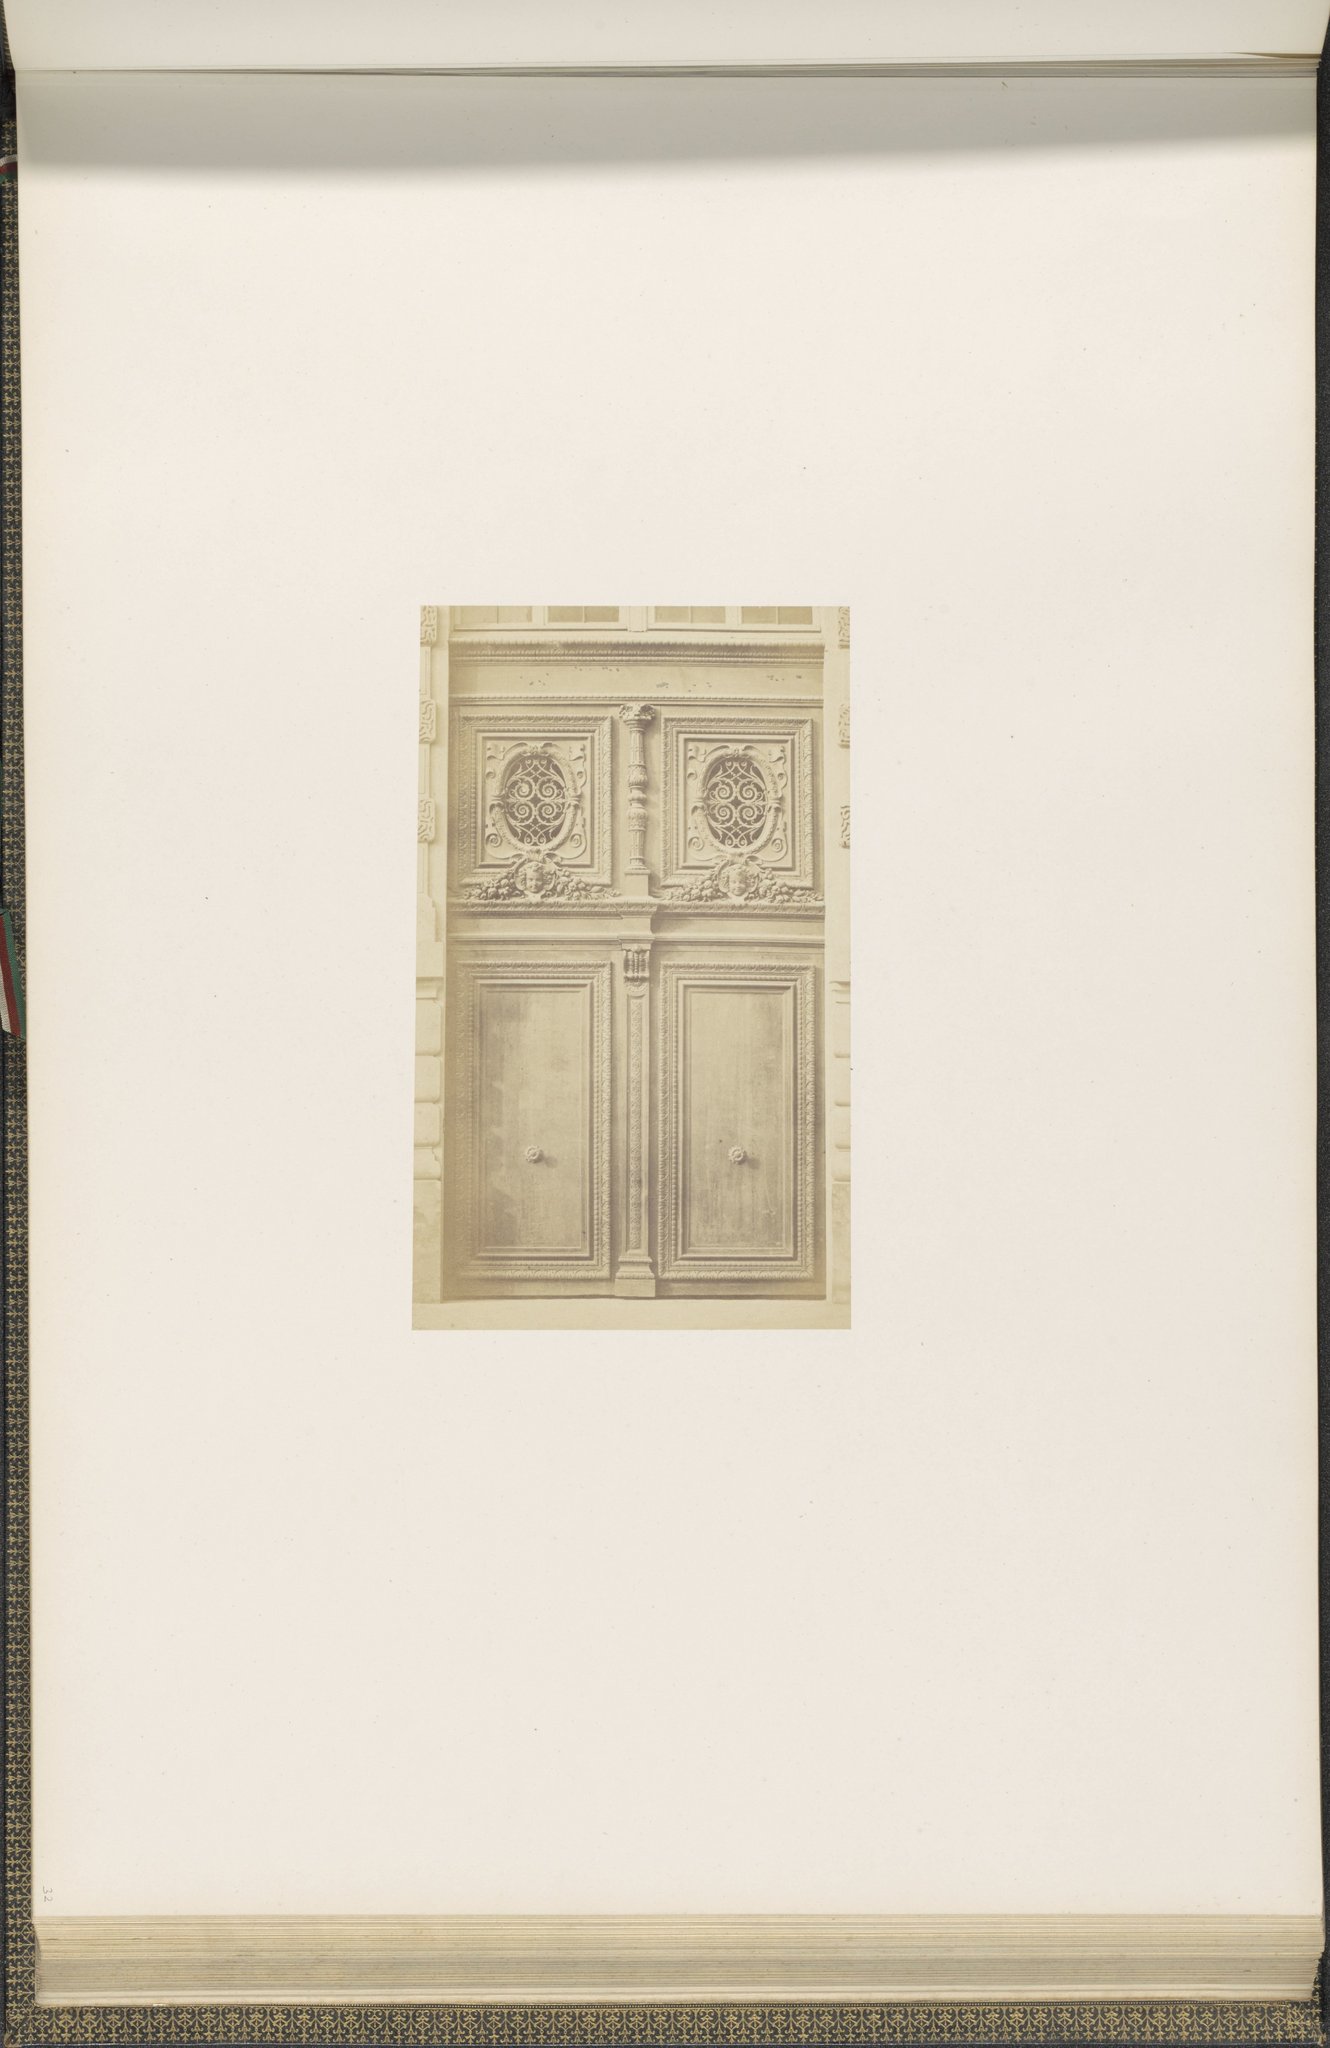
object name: photograph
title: Deur van de Bibliothèque Impériale van het Palais du Louvre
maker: édouard denis baldus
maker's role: fotograaf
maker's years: 1813-1889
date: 1855-1857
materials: paper, photographic support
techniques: salted paper print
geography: paris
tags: door, permanent exhibition, museum, ornamenting, decorating ~ applied arts, paris, tuileries palace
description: Onderdeel van Réunion des Tuileries au Louvre 1852-1857, album 4.